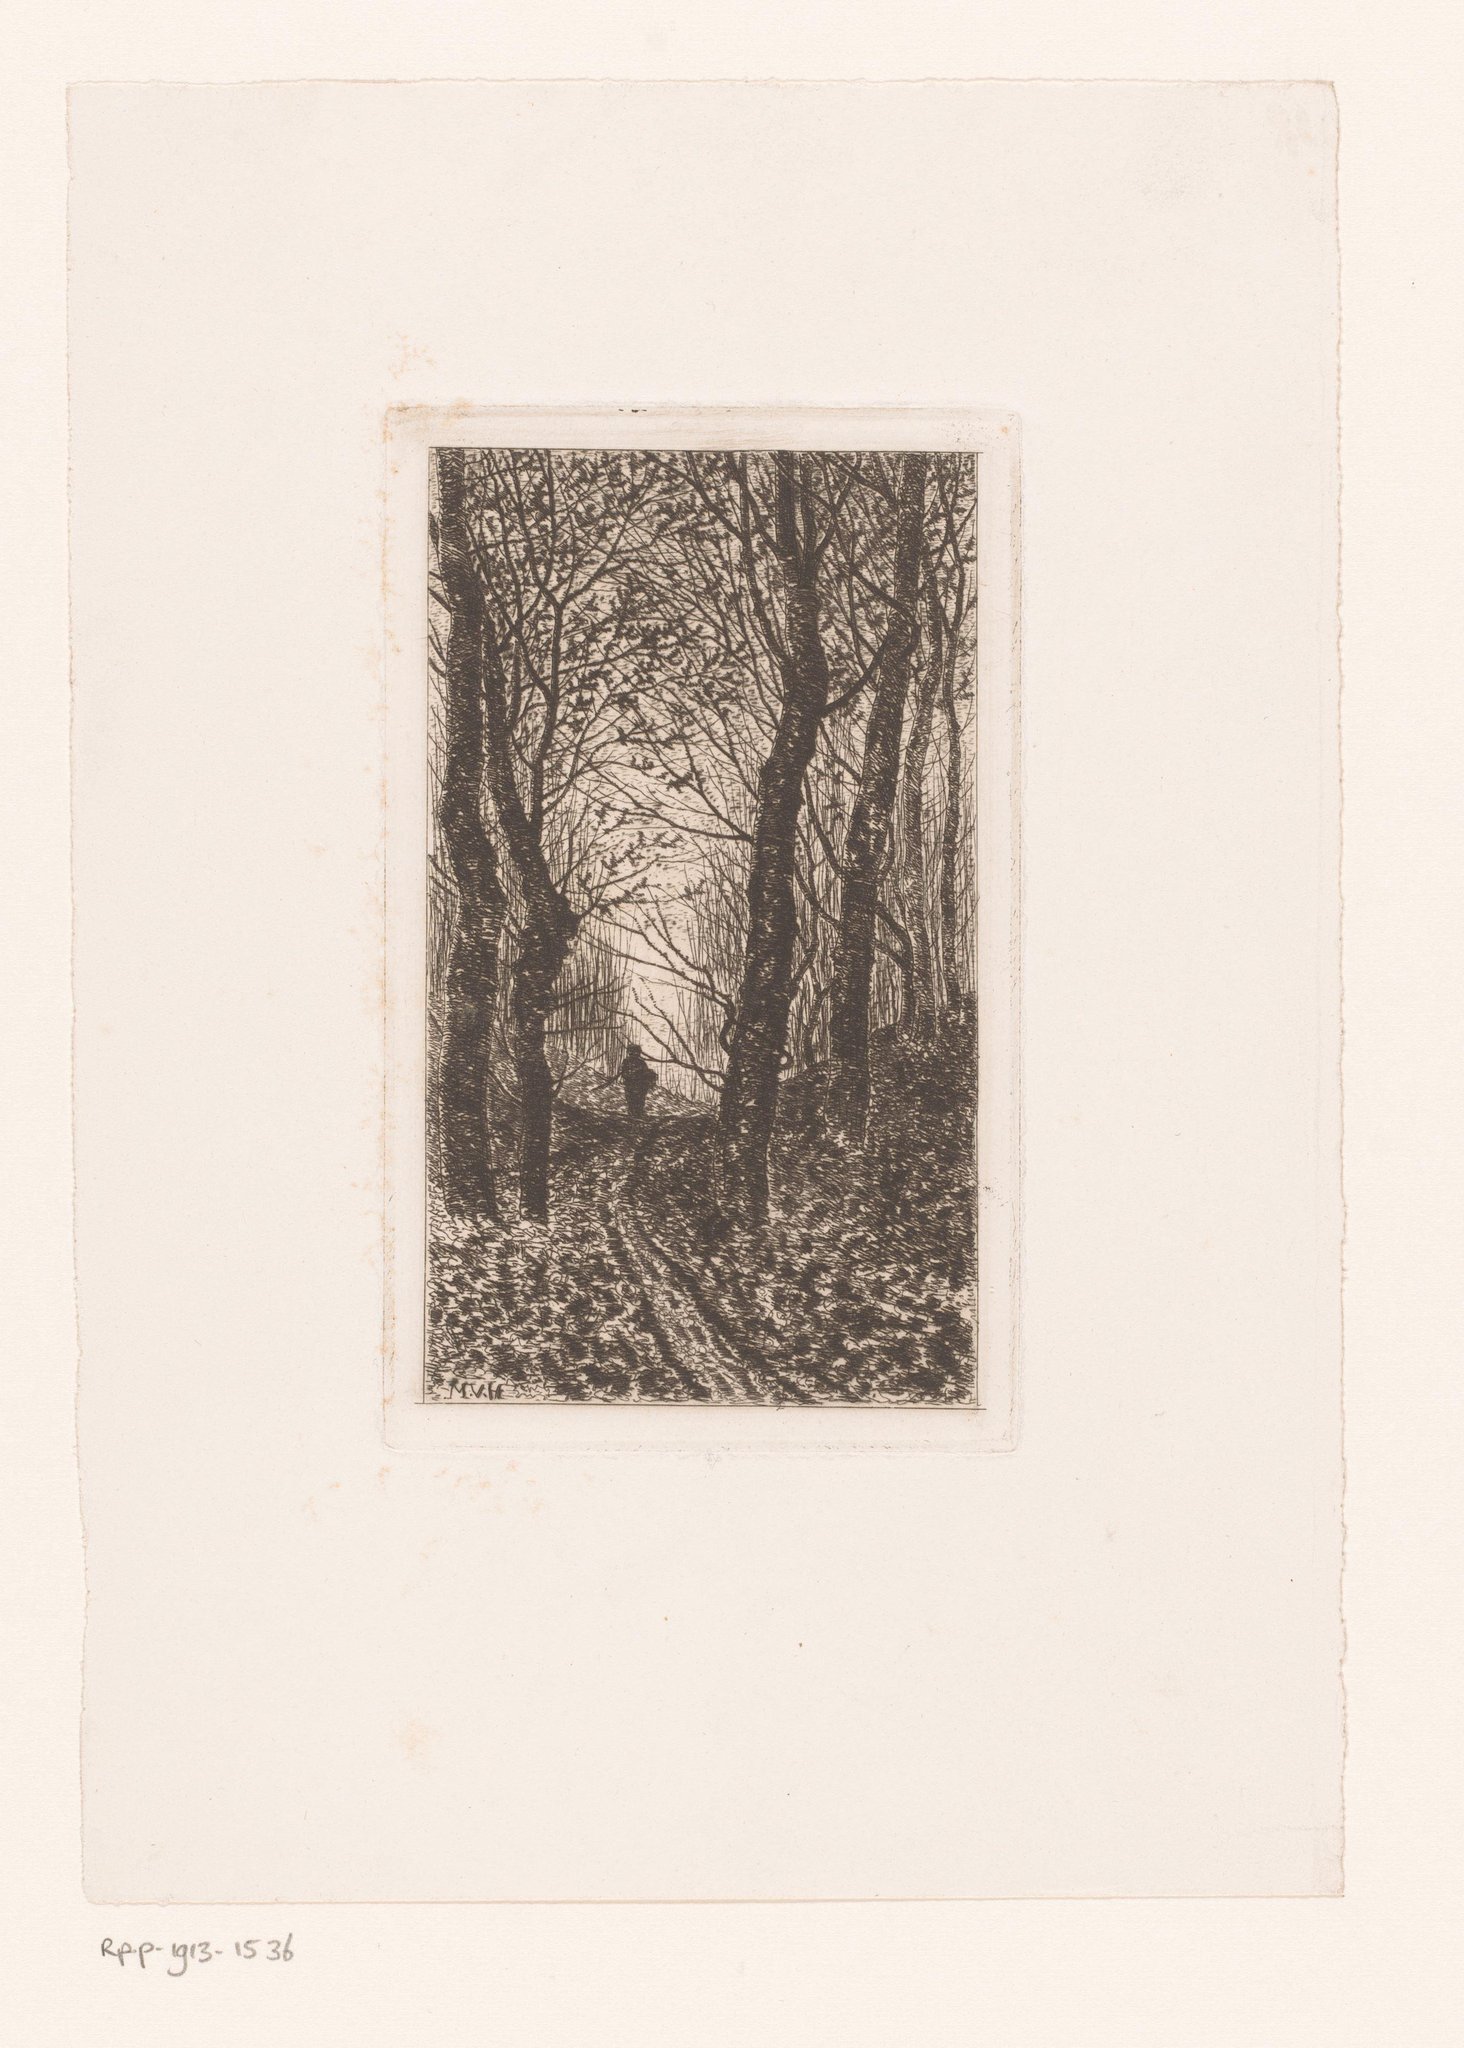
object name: print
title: Heuvelachtige bosweg met figuur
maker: h. van meerbeeck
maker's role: print maker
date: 1850-1913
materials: paper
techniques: etching, intaglio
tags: low hill country, forest path or lane (+ landscape with figures, staffage)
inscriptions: collector's mark: Lugt 2228